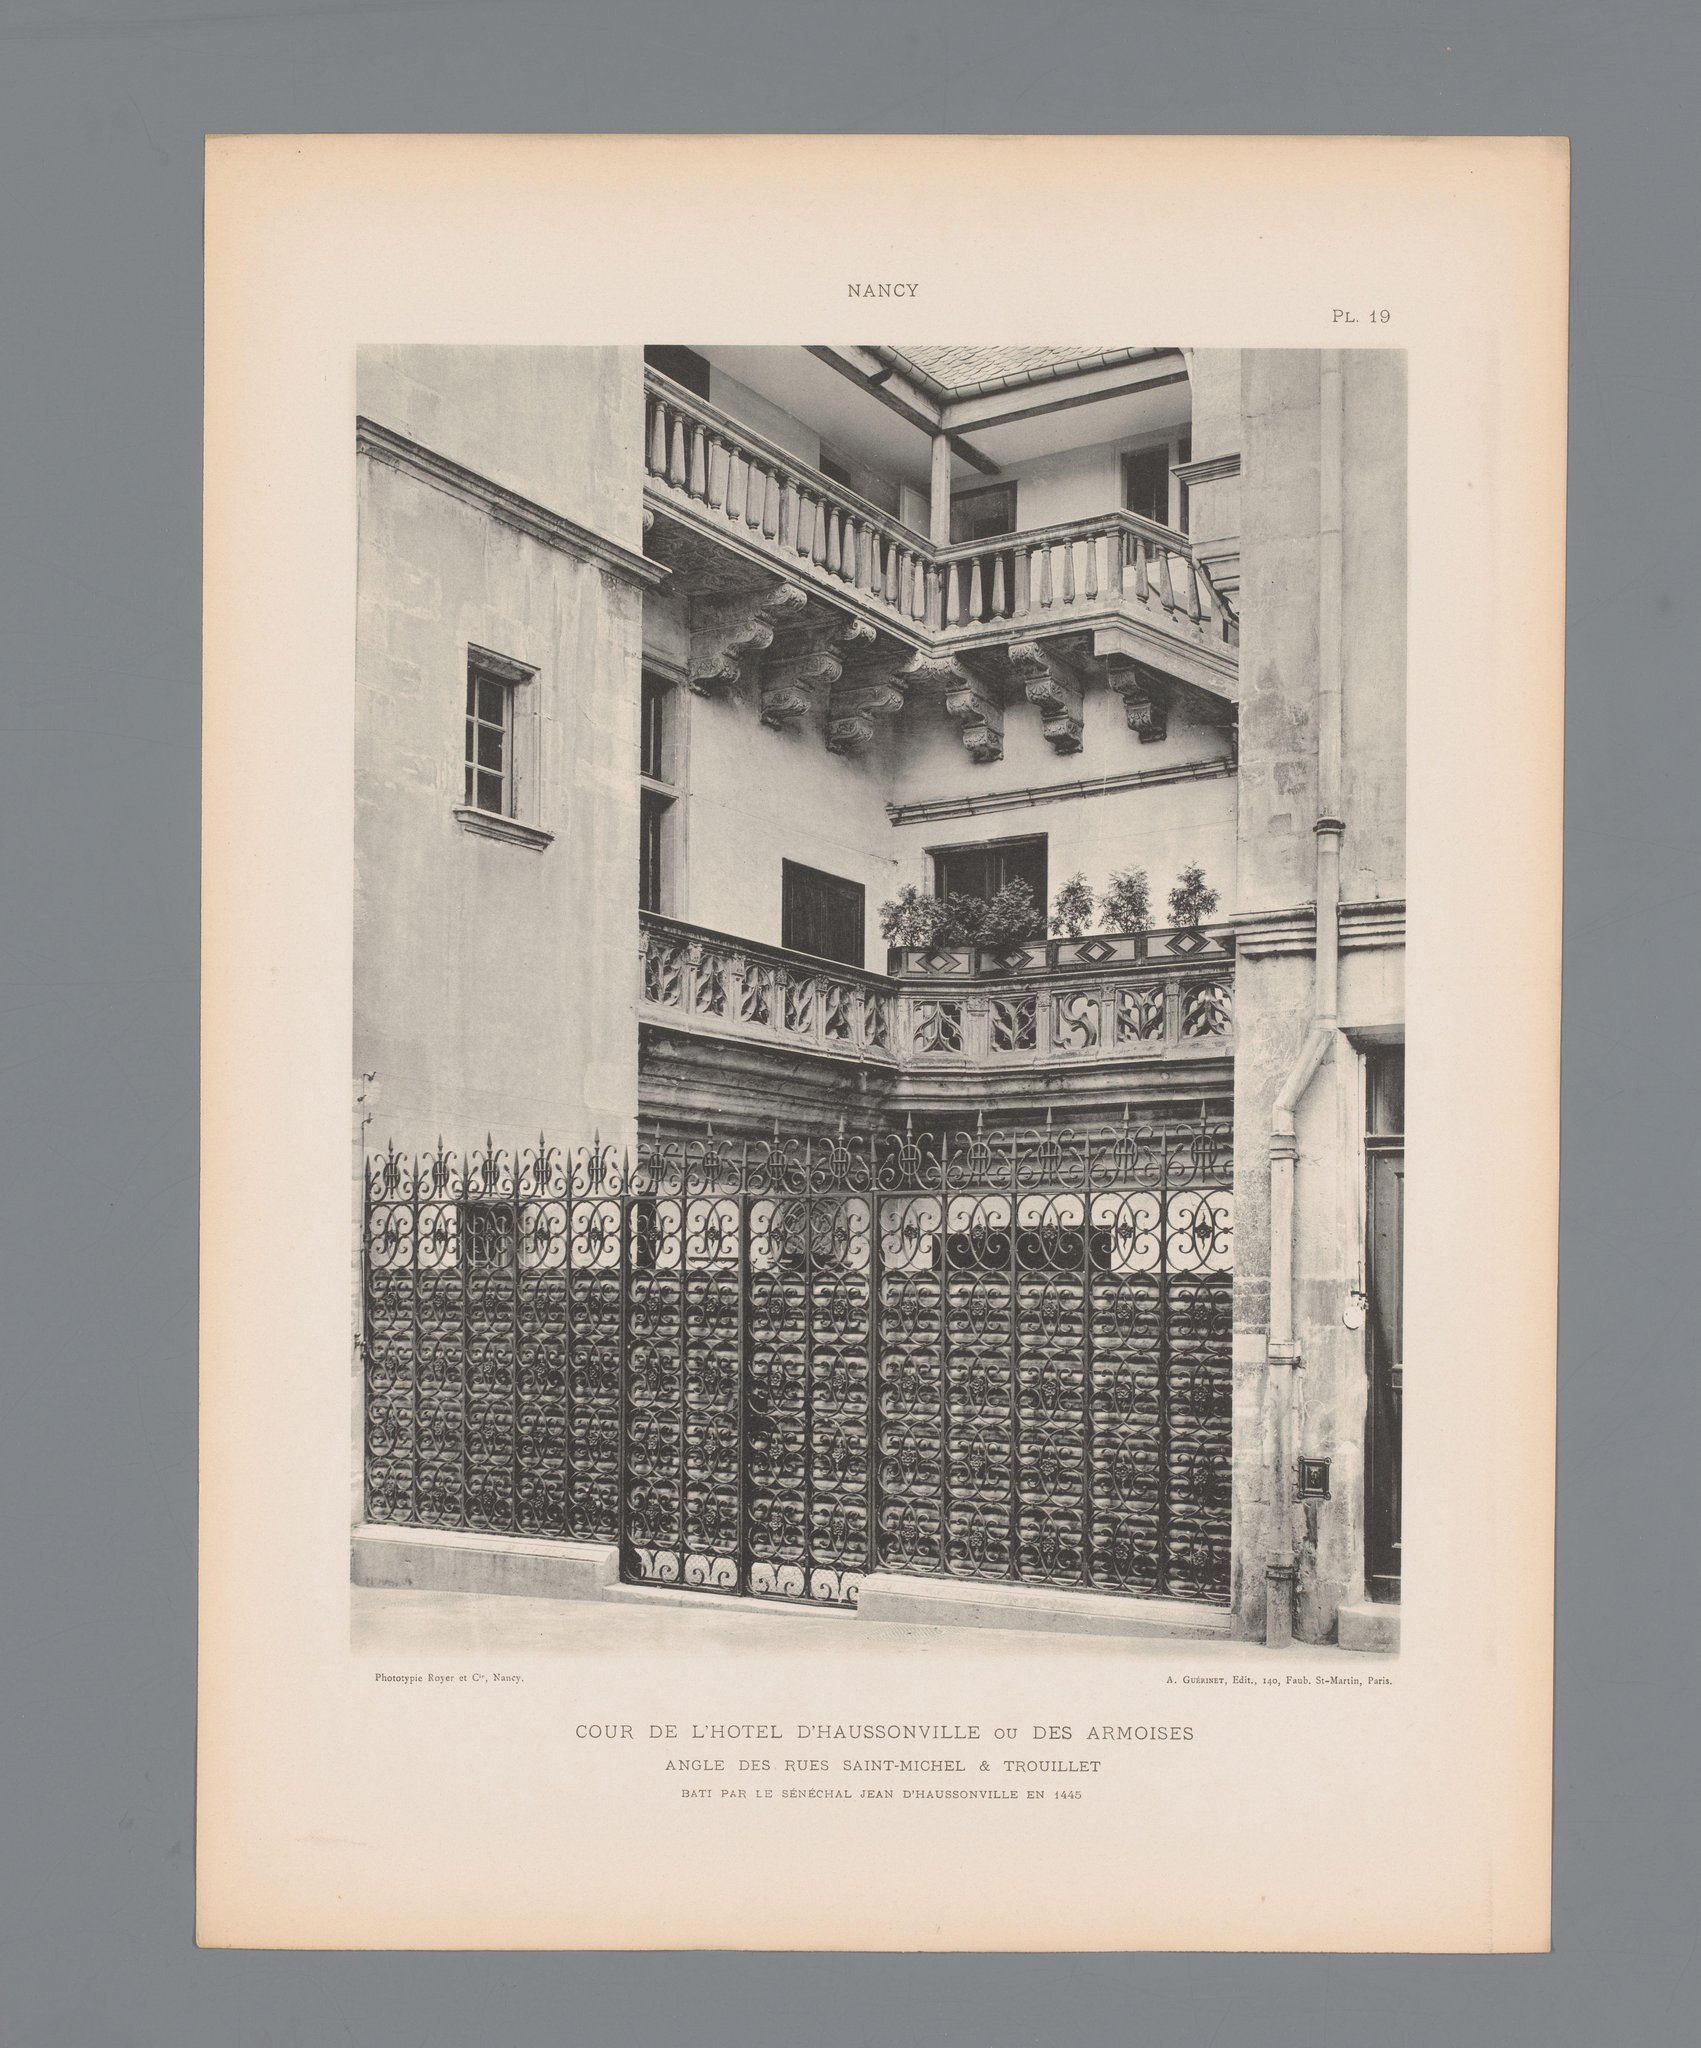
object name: photomechanical print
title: Hotel D'Haussonville te Nancy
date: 1891-1896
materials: paper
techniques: photograph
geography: nancy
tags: hotel, hostelry, inn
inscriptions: inscription: ‘Cour de l'Hotel D'haussonville ou des armoises (...)’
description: Deze prent maakt deel uit van een omslag met 103 prenten op 101 bladen en een titelblad.